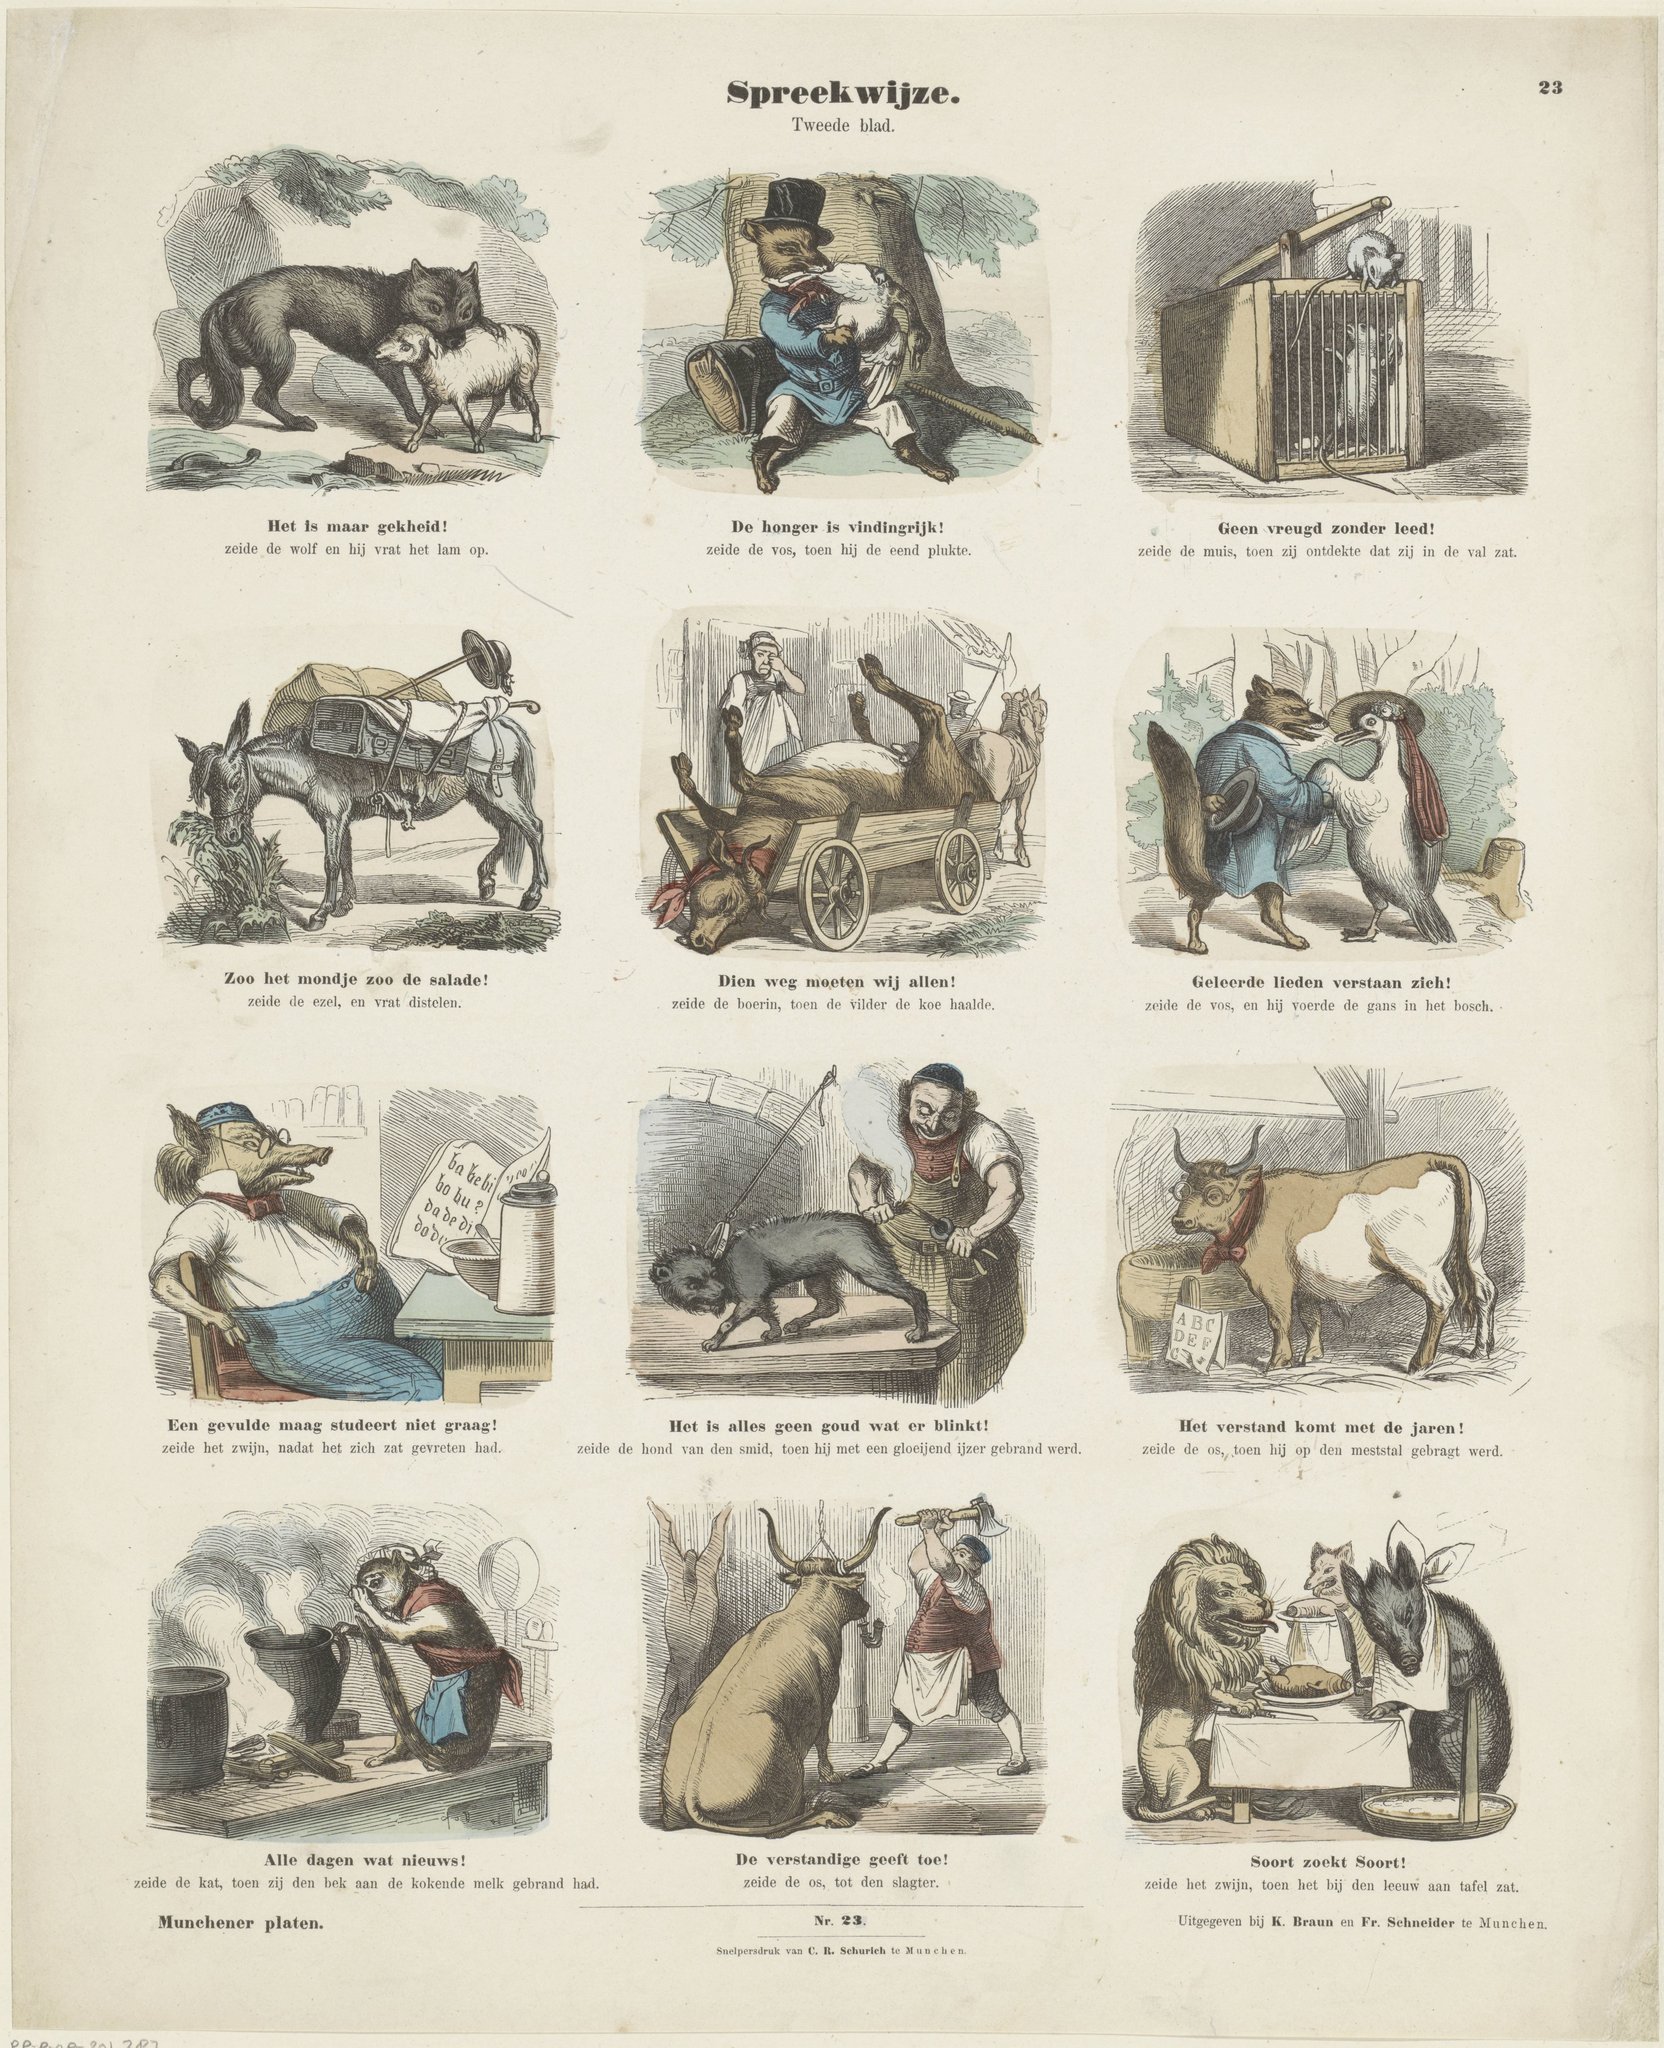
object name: popular print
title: Spreekwijze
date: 1843-1920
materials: paper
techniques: colour, letterpress printing, engraving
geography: munich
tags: animals, animals acting as human beings, proverbs, sayings, etc.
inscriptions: collector's mark: Lugt 2760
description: Blad met 12 verbeeldingen van spreekwoorden door komische taferelen met dieren. Onder elke afbeelding een onderschrift. Genummerd midden onder: Nr. 23. Genummerd rechtsboven: 23.